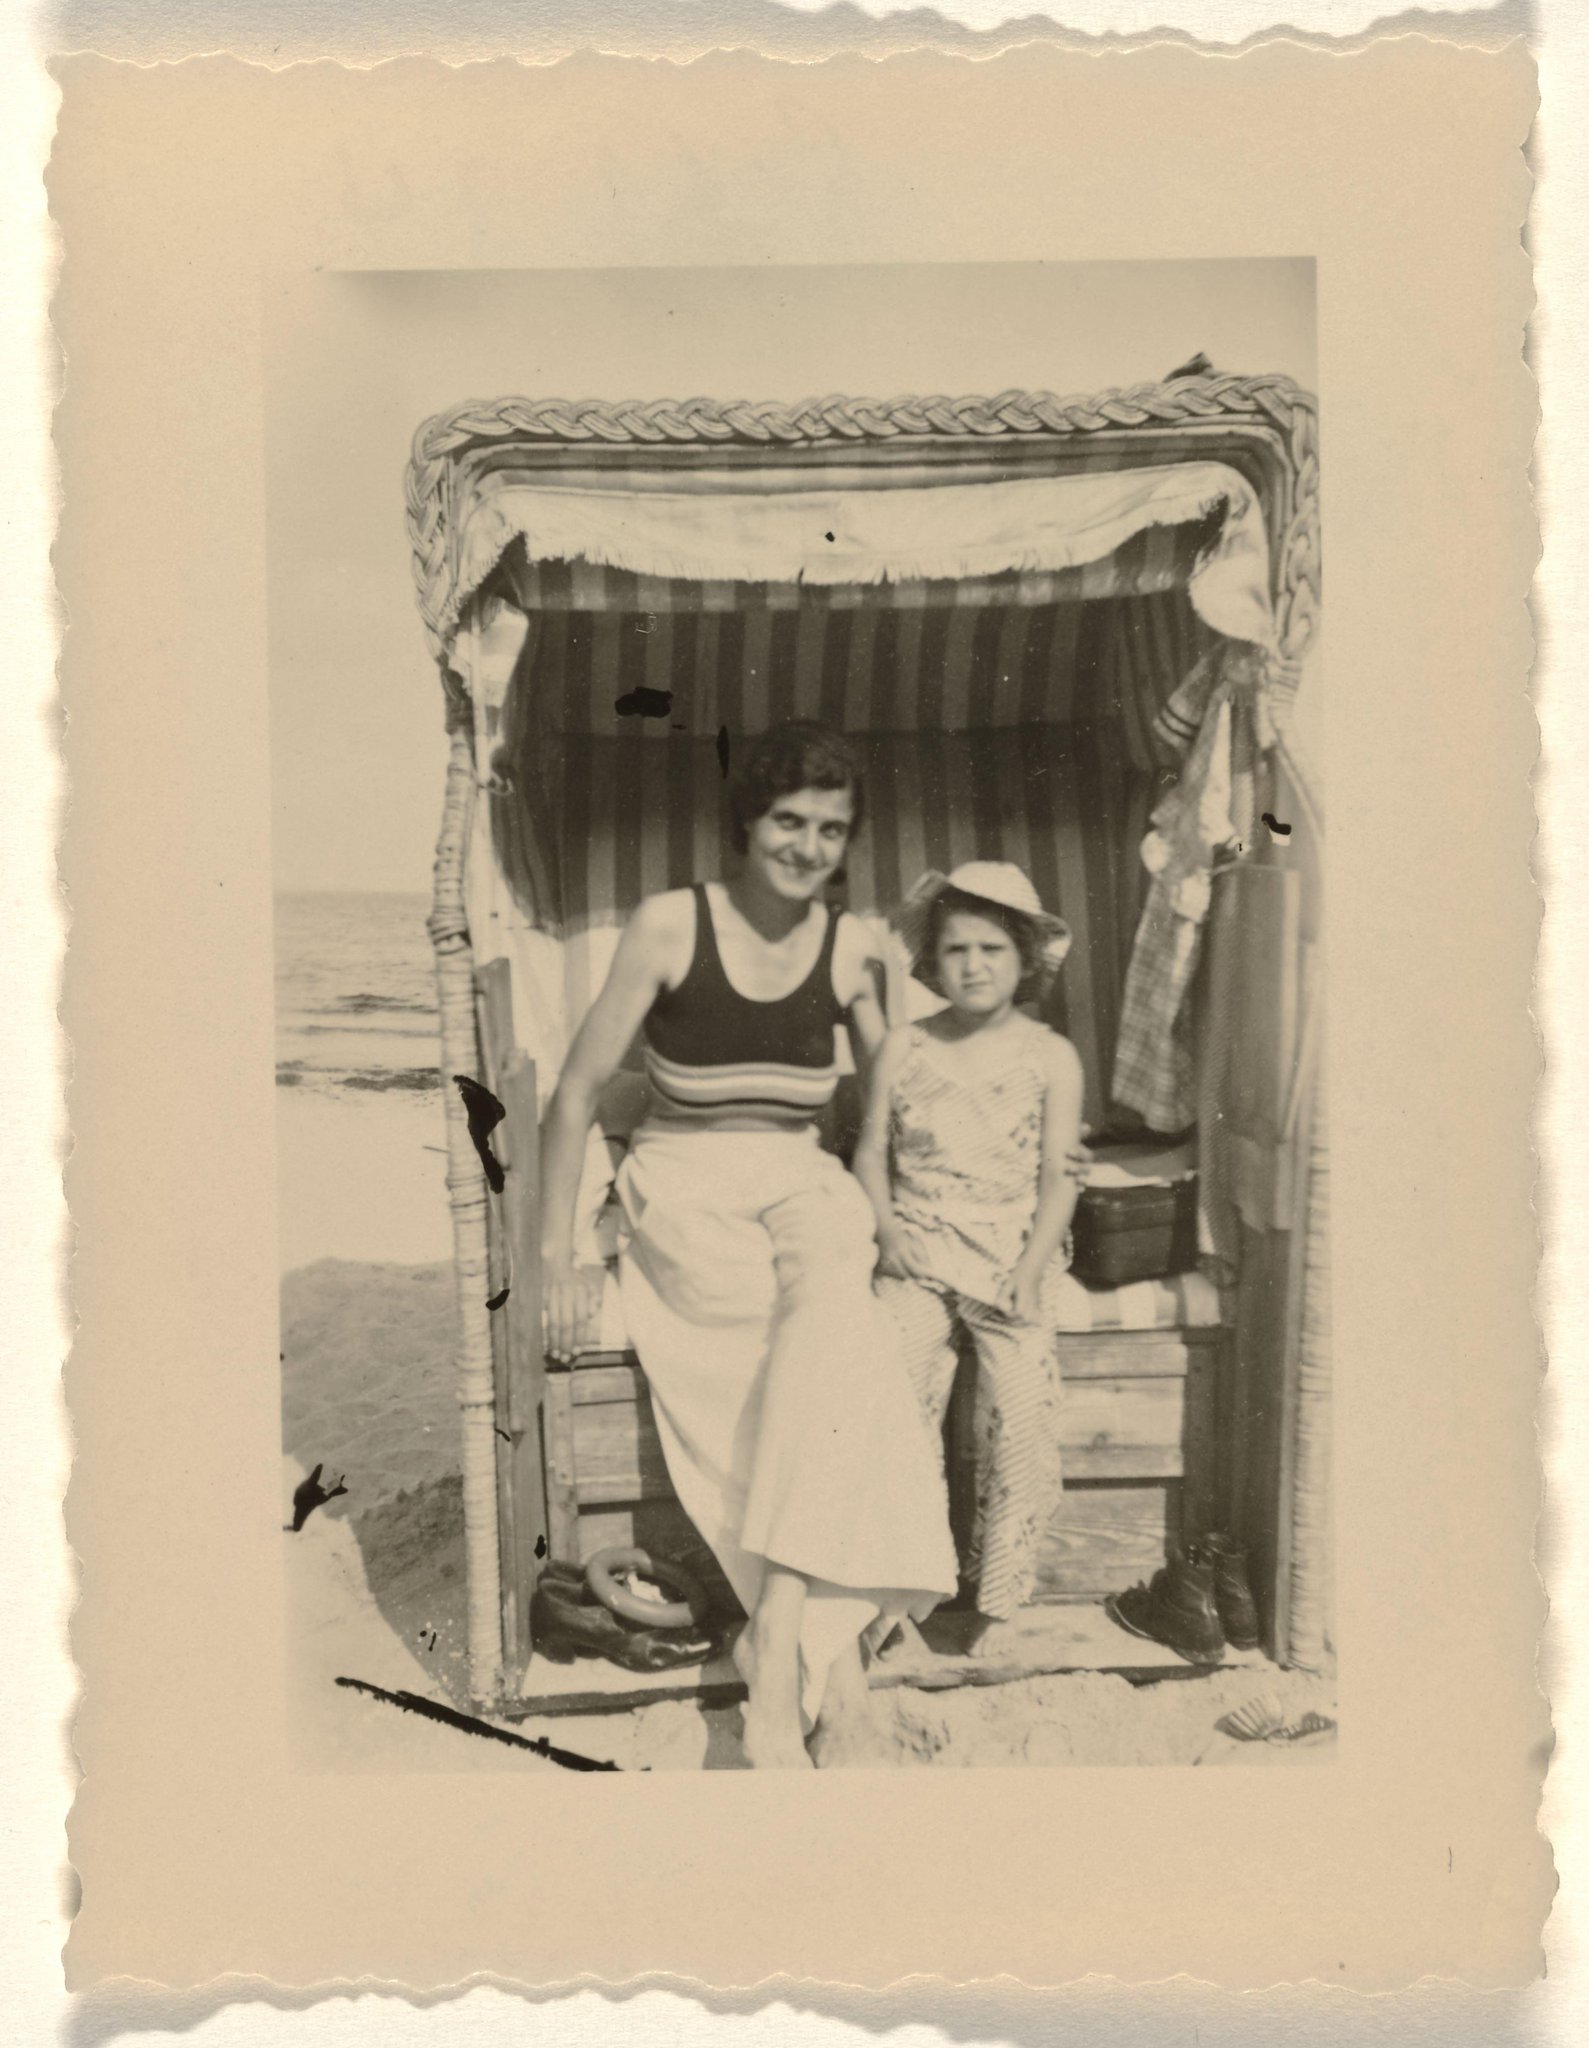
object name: photograph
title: Isabel Wachenheimer in strandkorf op strand van Scharbeutz, september 1934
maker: Anonymous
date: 1909-1934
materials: photographic support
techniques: gelatin silver print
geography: scharbeutz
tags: leiden, isabel wachenheimer-elon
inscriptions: date: ‘Sept.34. 2 Bade-Nixen in ,,Körbchen''’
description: Dit object is onderdeel van de nalatenschap van Isabel Elon-Wachenheimer (1928-2010). Tot haar overlijden behoorde het samen met de andere objecten uit de nalatenschap tot haar privédomein van Isabel Wachenheimer. In die particuliere context zijn deze objecten tezamen en individueel aandenkens - aan de jeugd, ouders en familie van Isabel Wachenheimer vóór en tijdens de Shoah en aan haar leven na de Tweede Wereldoorlog. Isabel Wachenheimer, die van juni 1943 tot mei 1945 gevangen zat in Kamp Westerbork, Theresienstadt, Auschwitz, Lenzing a/d Oberdonau (een buitenkamp van Mauthausen), overleefde de Shoah. Haar ouders – Eugène Wachenheimer en Else Wachenheimer-Moos - werden op 14 oktober 1944 in Auschwitz-Birkenau vermoord.